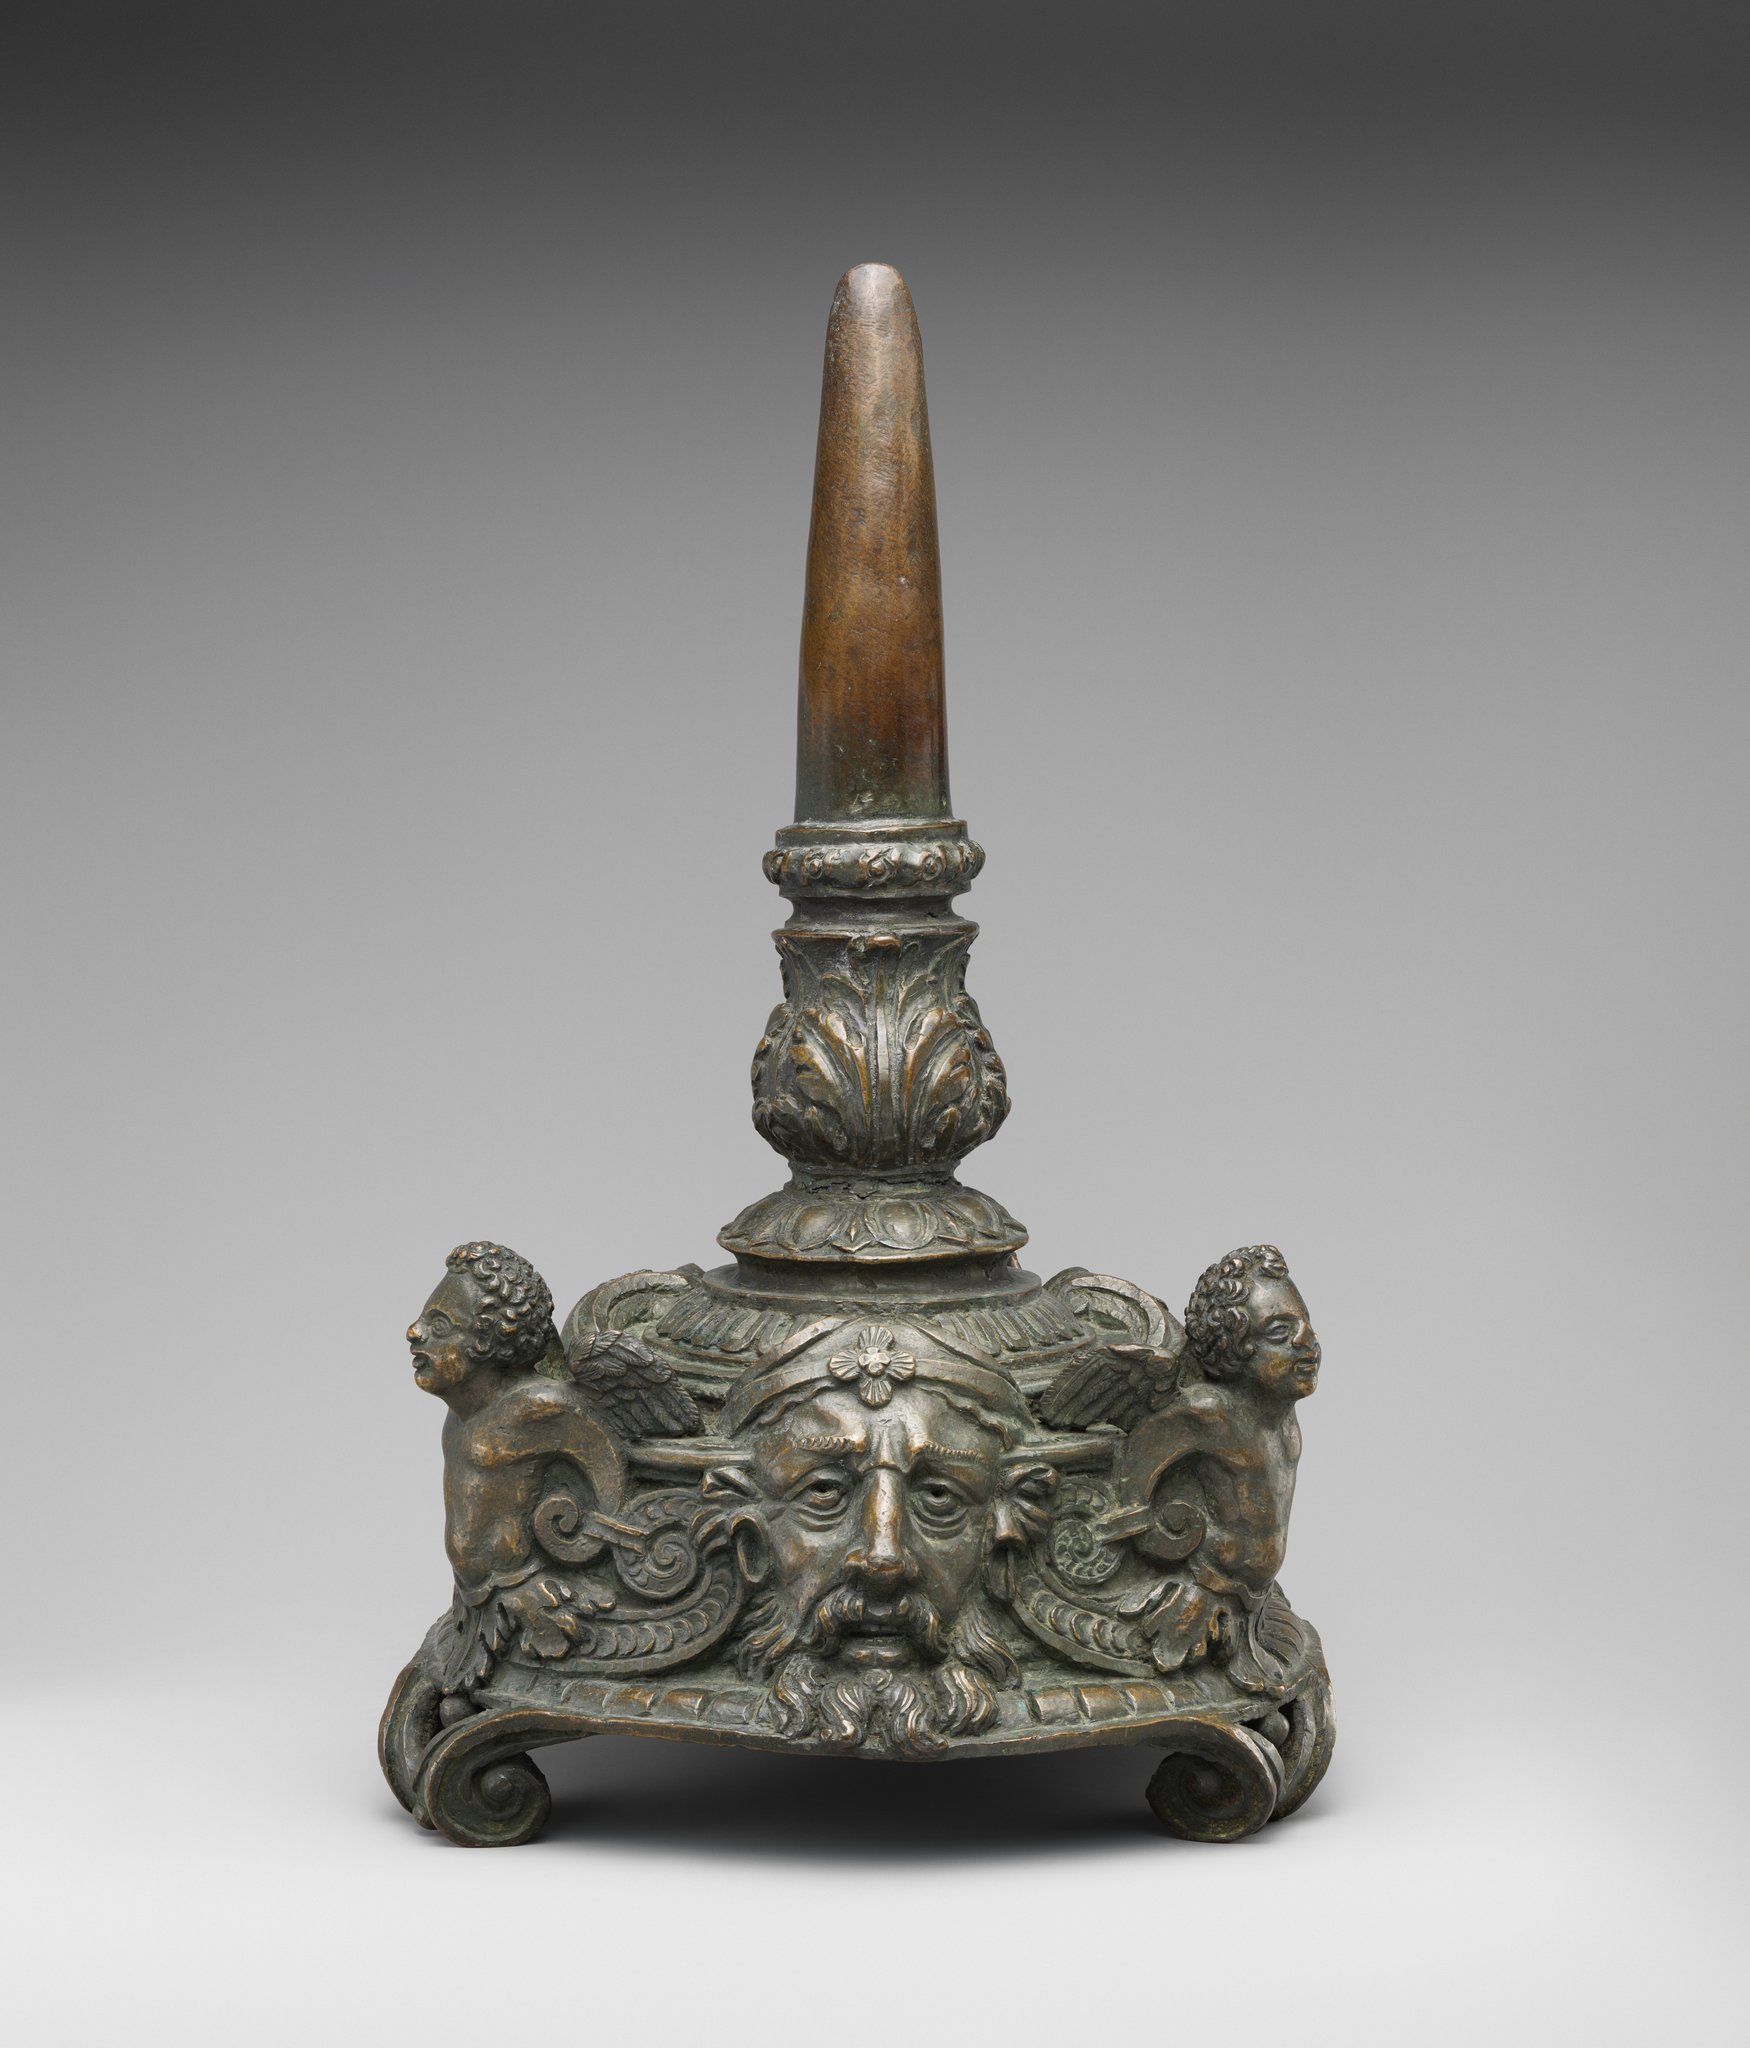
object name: candlestick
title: Pricket candlestick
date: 1501-1600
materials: bronze